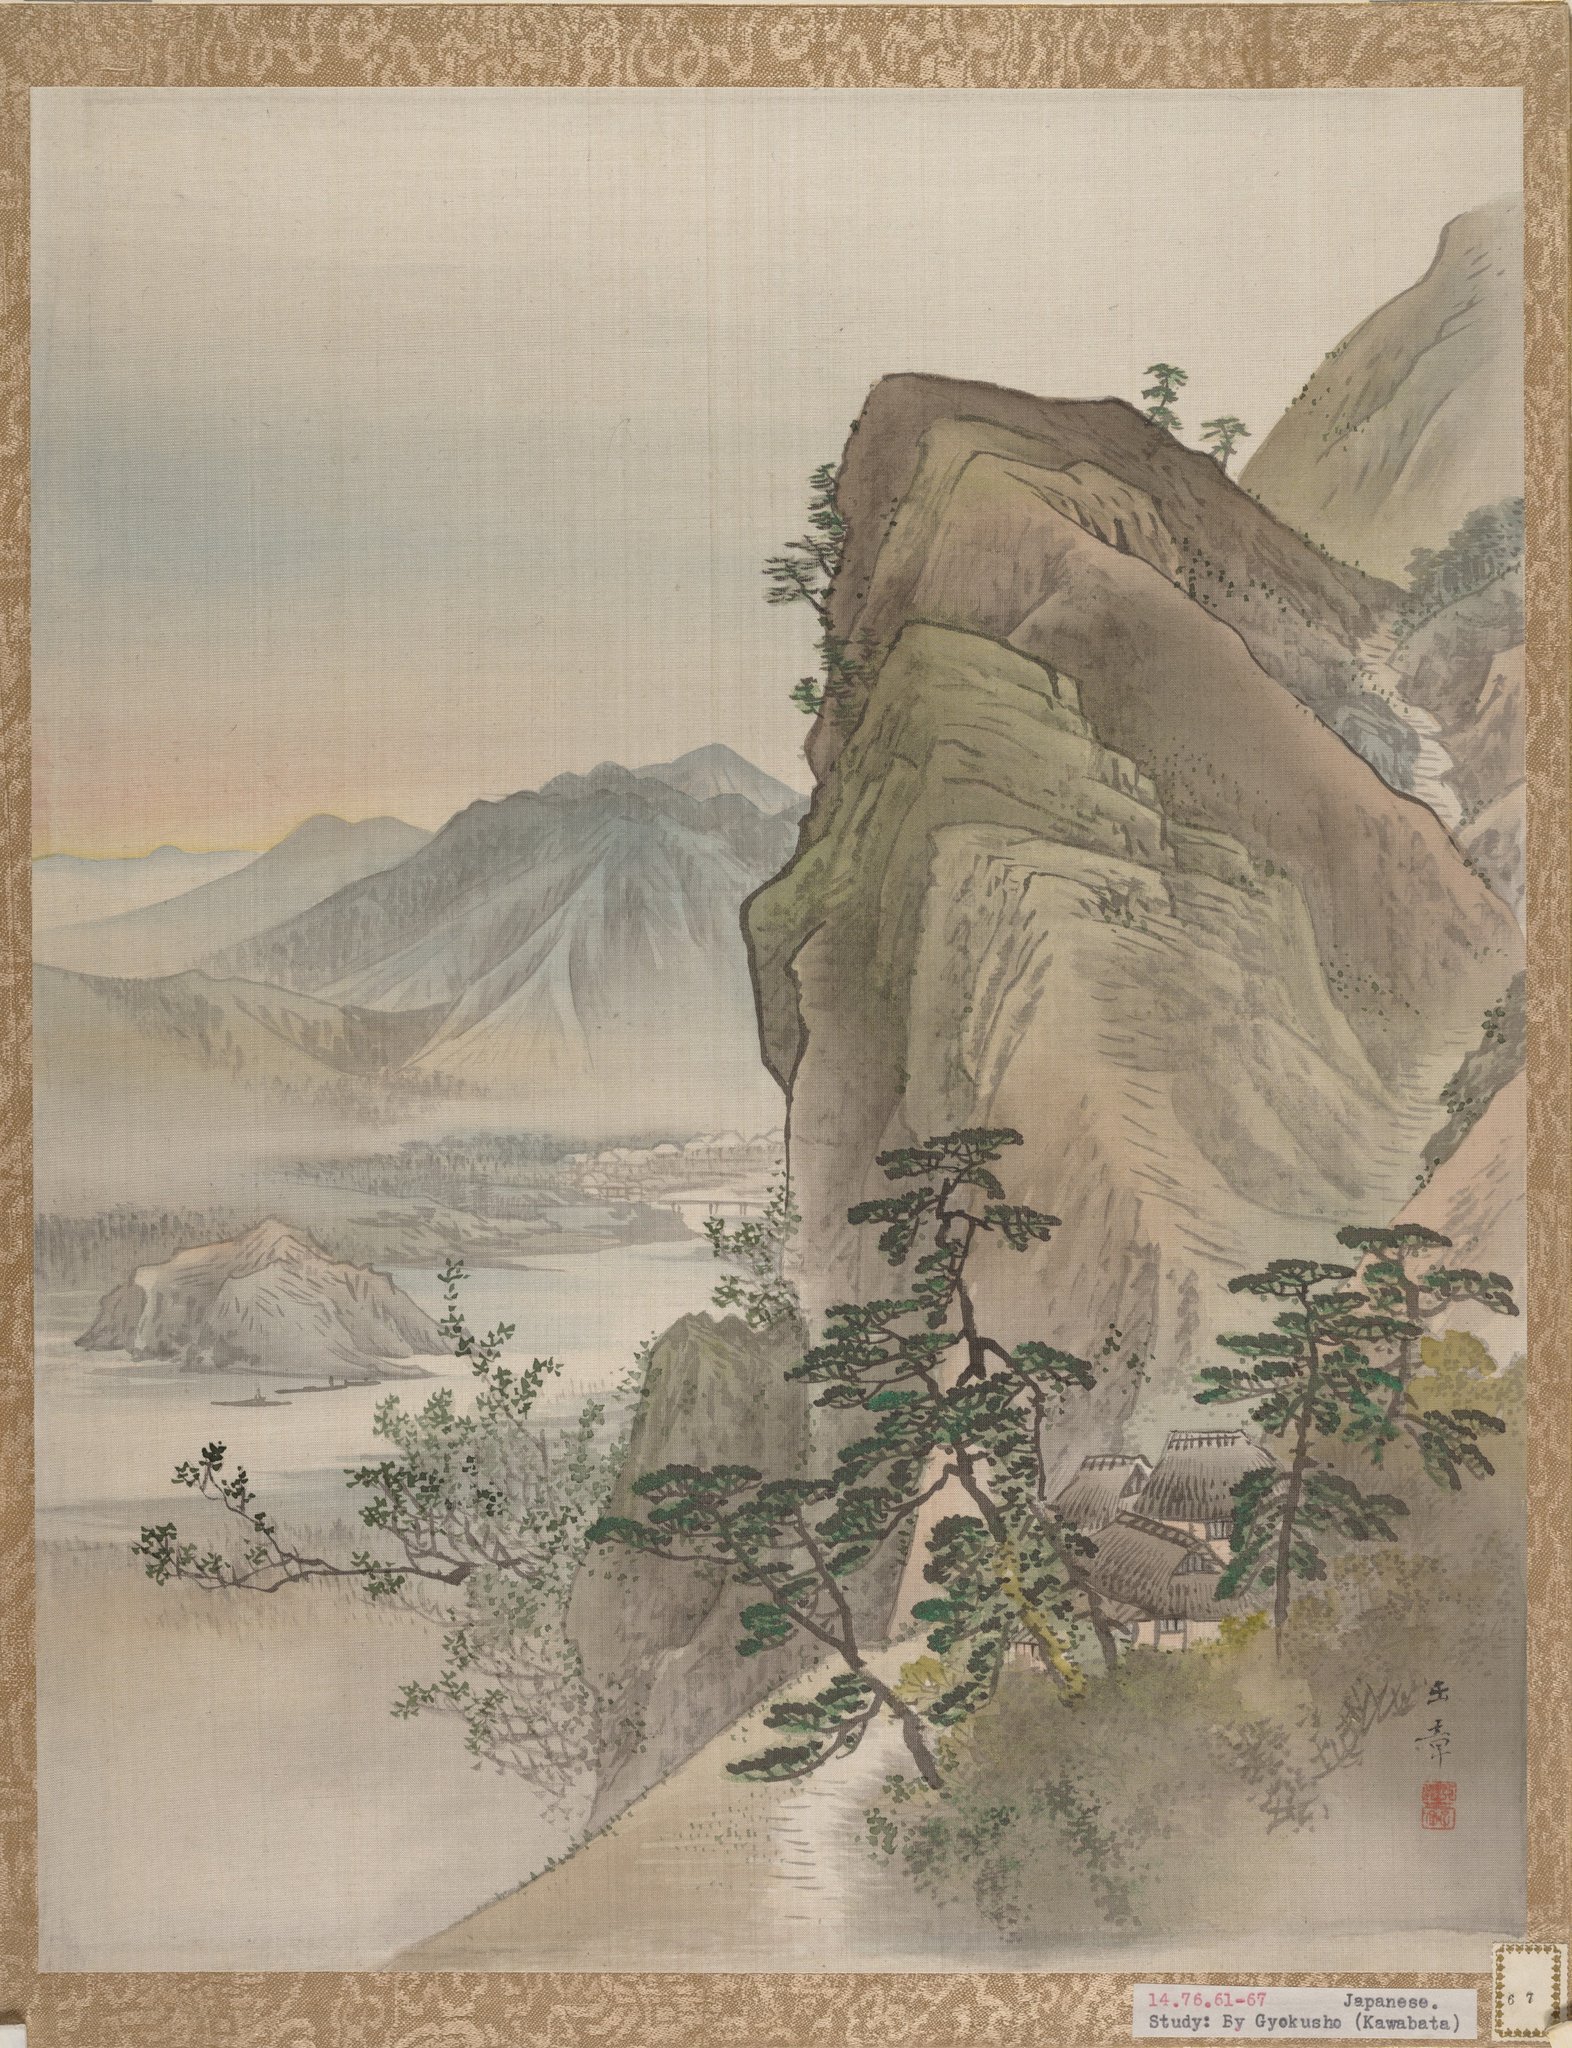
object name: album leaf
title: Landscape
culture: japanese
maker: kawabata gyokushō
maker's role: artist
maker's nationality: japanese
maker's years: 1842-1913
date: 1887-1892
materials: ink, silk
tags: mountains,landscapes